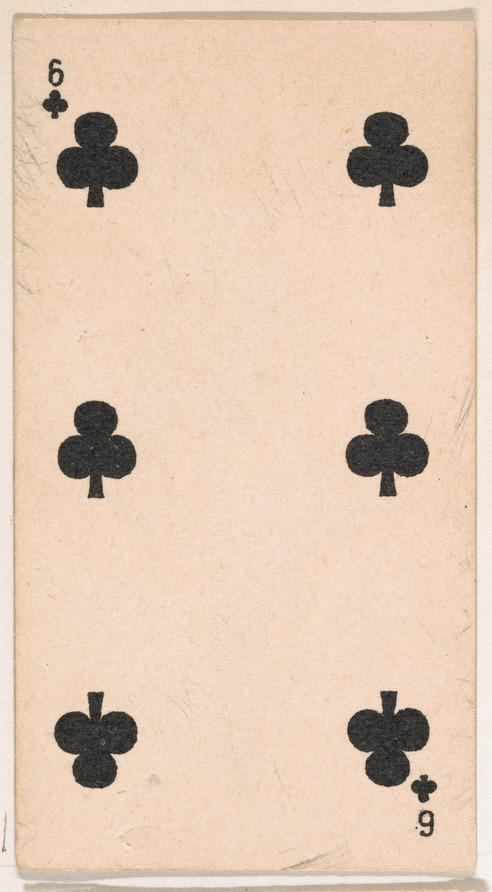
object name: print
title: Six of Clubs, from the Transparent Playing Cards series (N220) issued by Kinney Bros.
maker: kinney brothers tobacco company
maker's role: publisher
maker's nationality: american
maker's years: 1869-2011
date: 1888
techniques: color lithograph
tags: playing cards